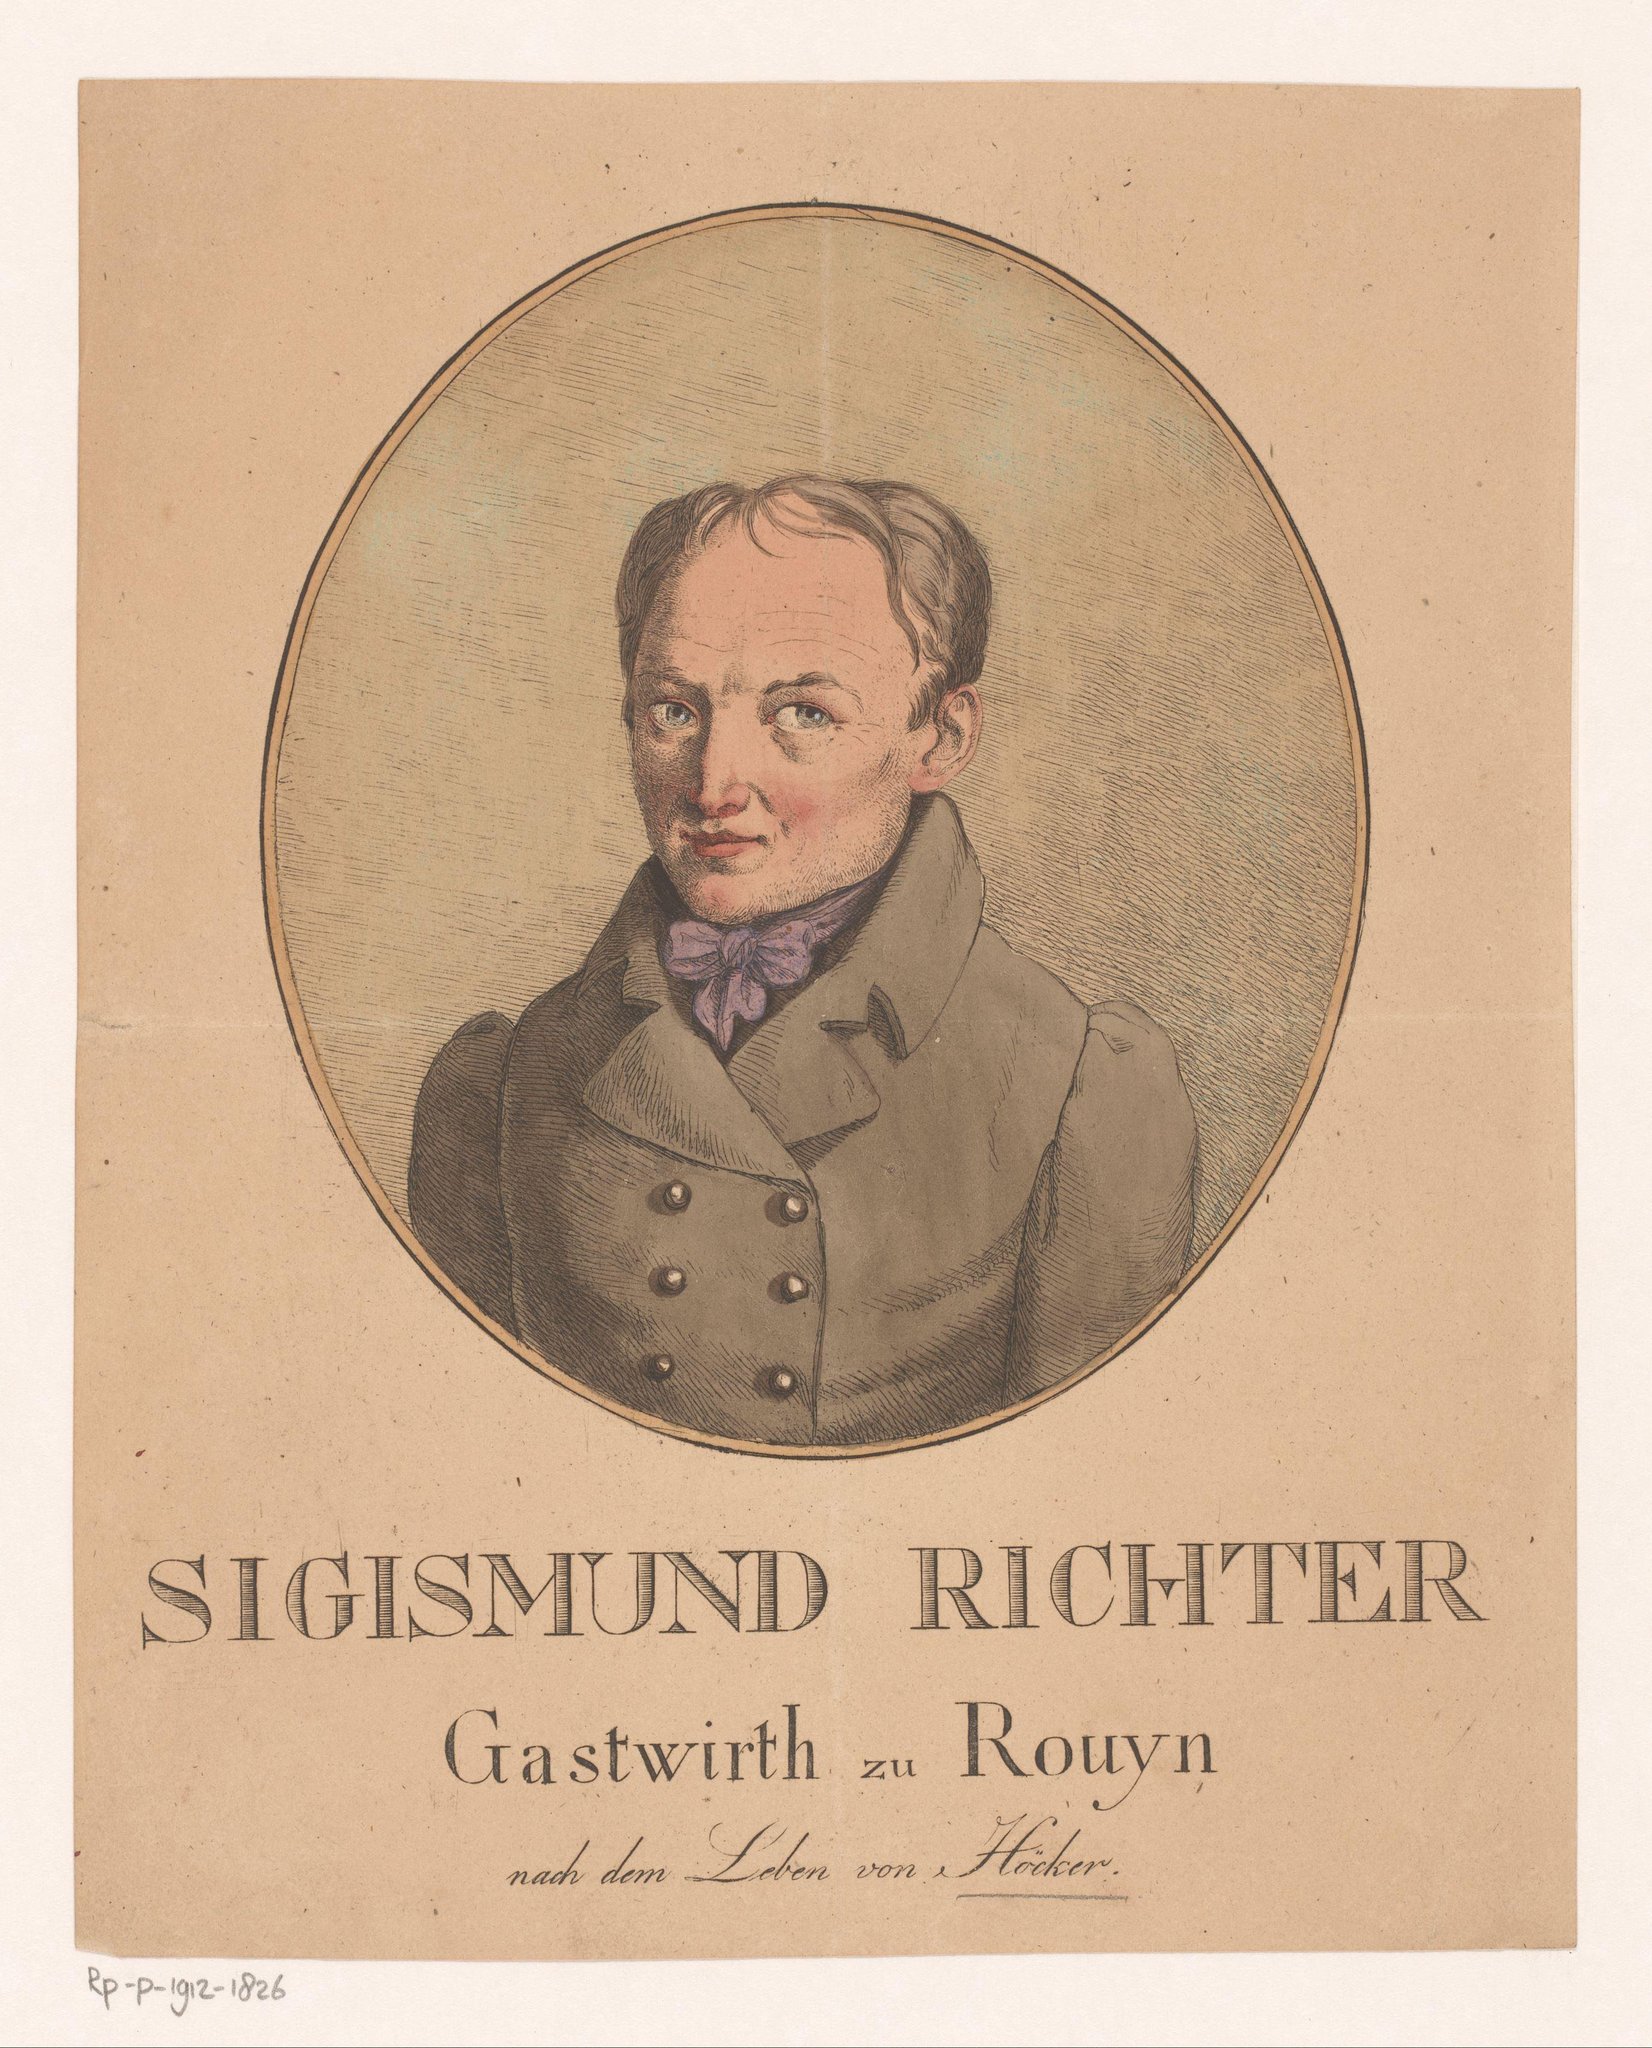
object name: print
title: Portret van Sigismund Richter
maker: höcker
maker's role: painter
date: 1800-1899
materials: paper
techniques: etching, hand coloring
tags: historical persons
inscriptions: collector's mark: Lugt 2228